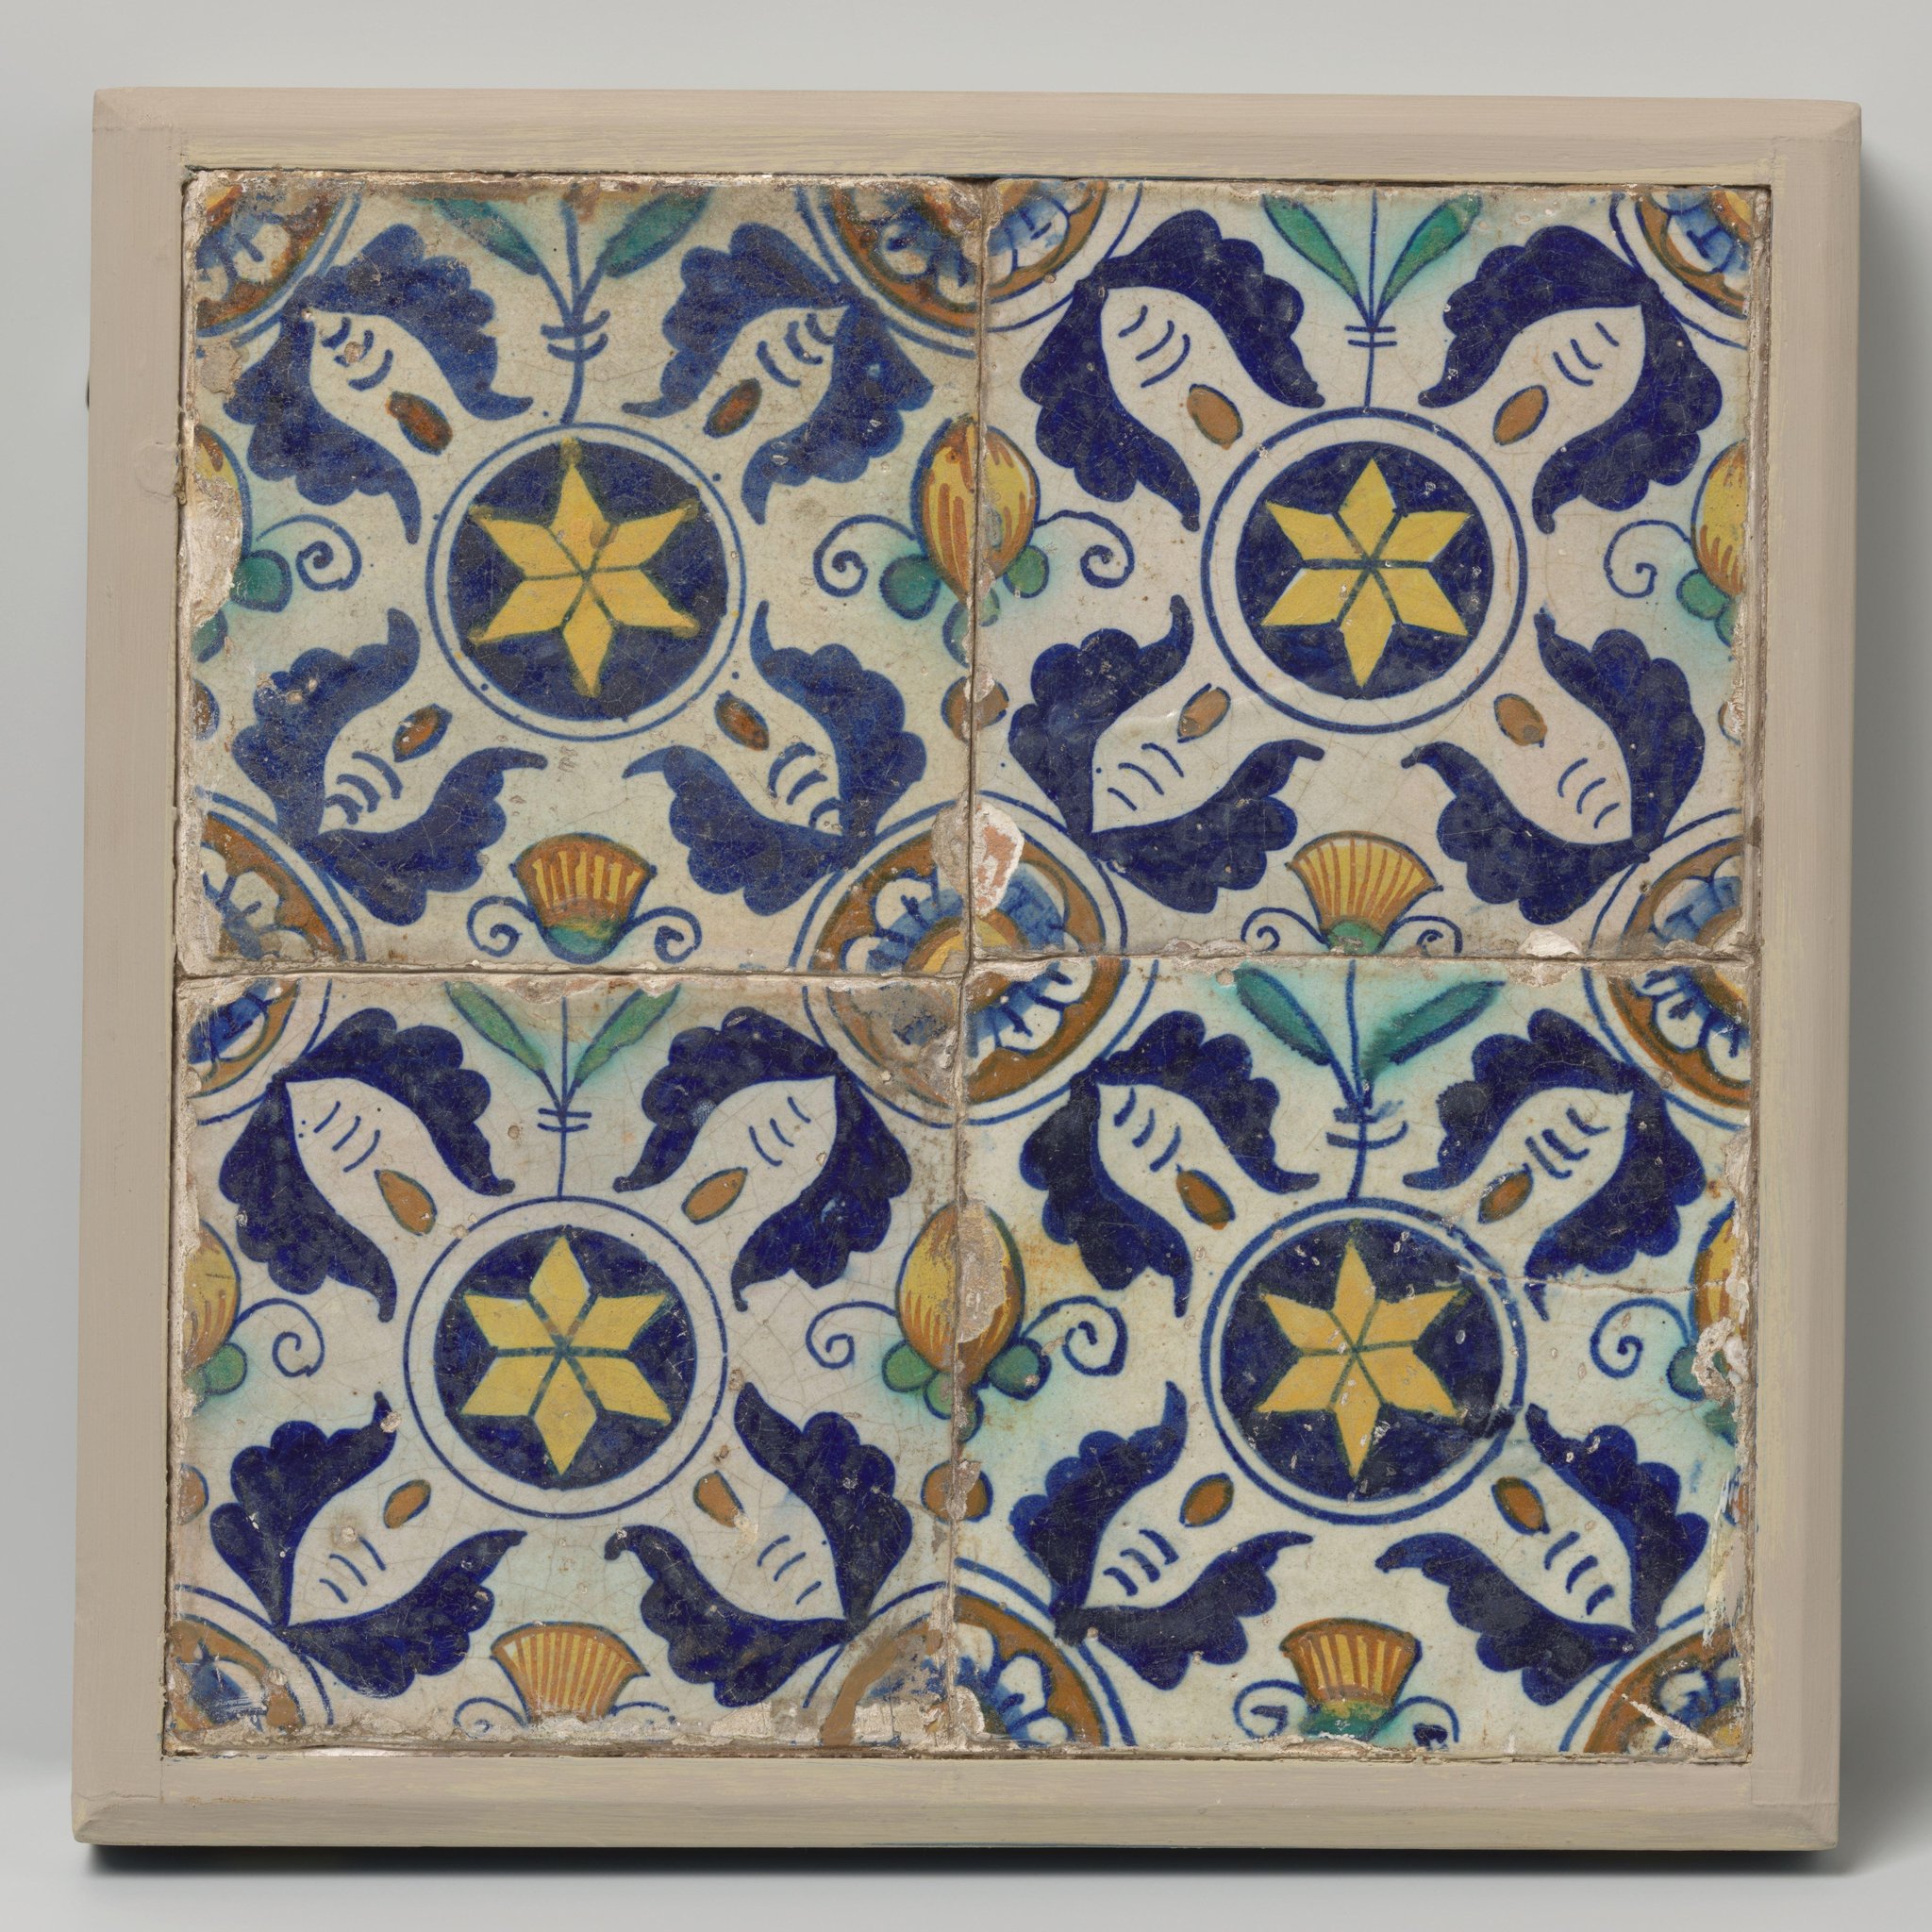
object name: tegelveld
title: Veld van vier tegels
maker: Anonymous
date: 1600-1630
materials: earthenware, glaze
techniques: maiolica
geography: netherlands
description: Veld van 4 tegels (2 x 2) elk met een veelkleurig (blauw, rood-oranje, geel en groen) geschilderde ster in een cirkel omgeven door bladpatronen. In de hoeken, een kwart rozet.